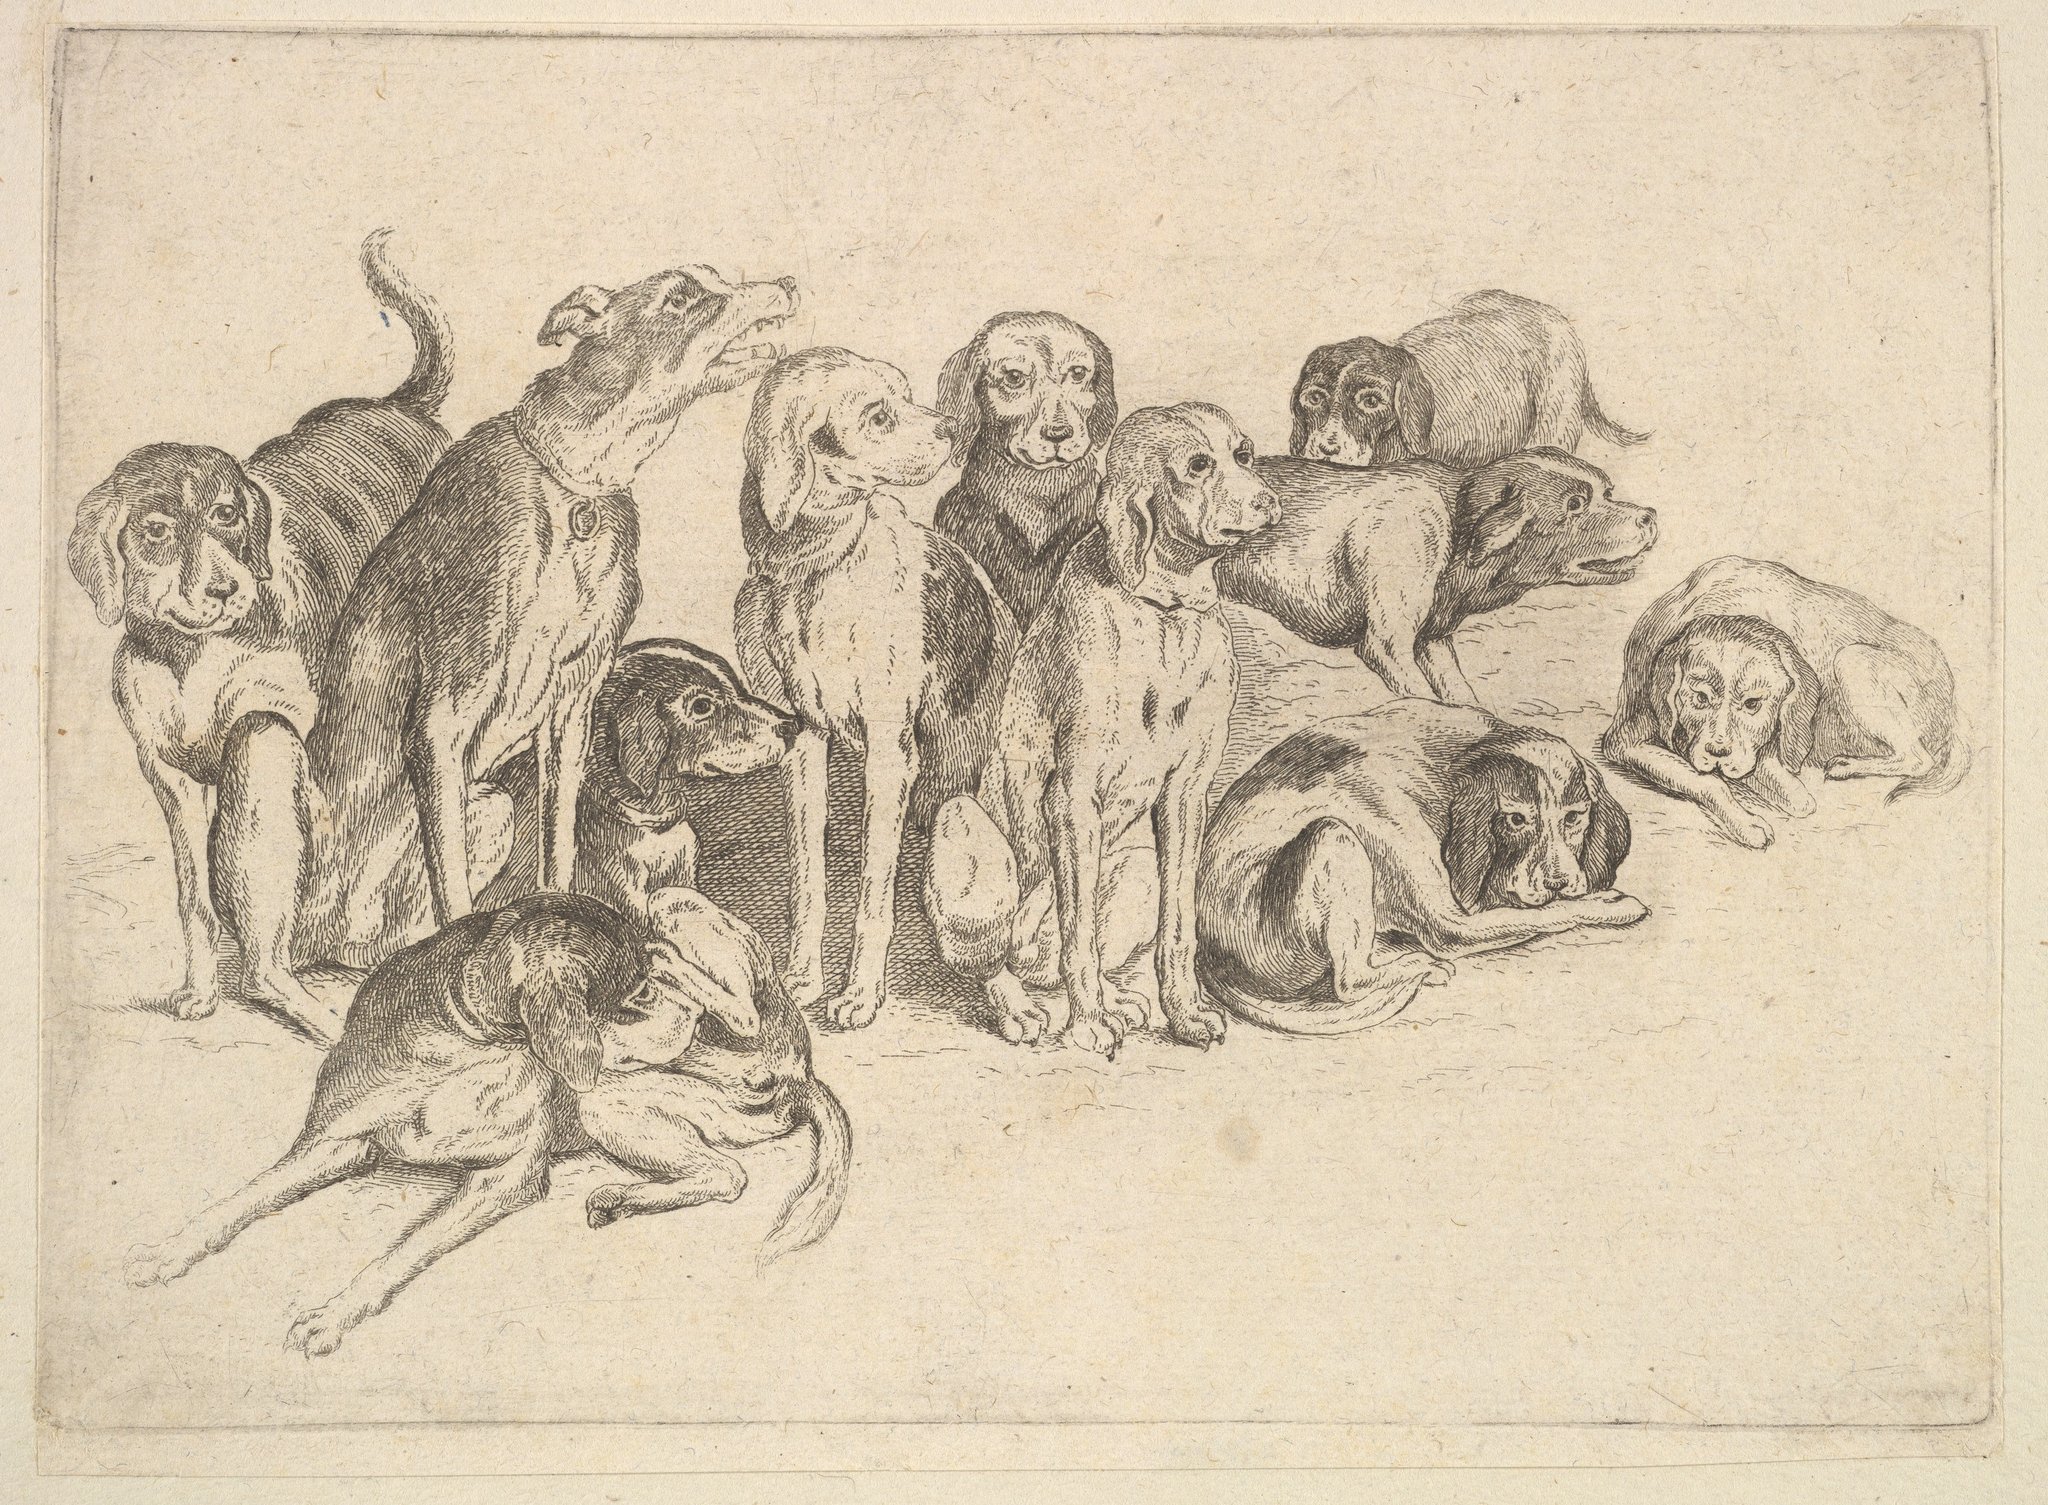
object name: print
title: Eleven Hounds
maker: wenceslaus hollar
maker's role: artist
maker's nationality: bohemian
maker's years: 1607-1677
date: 1646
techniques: etching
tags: dogs